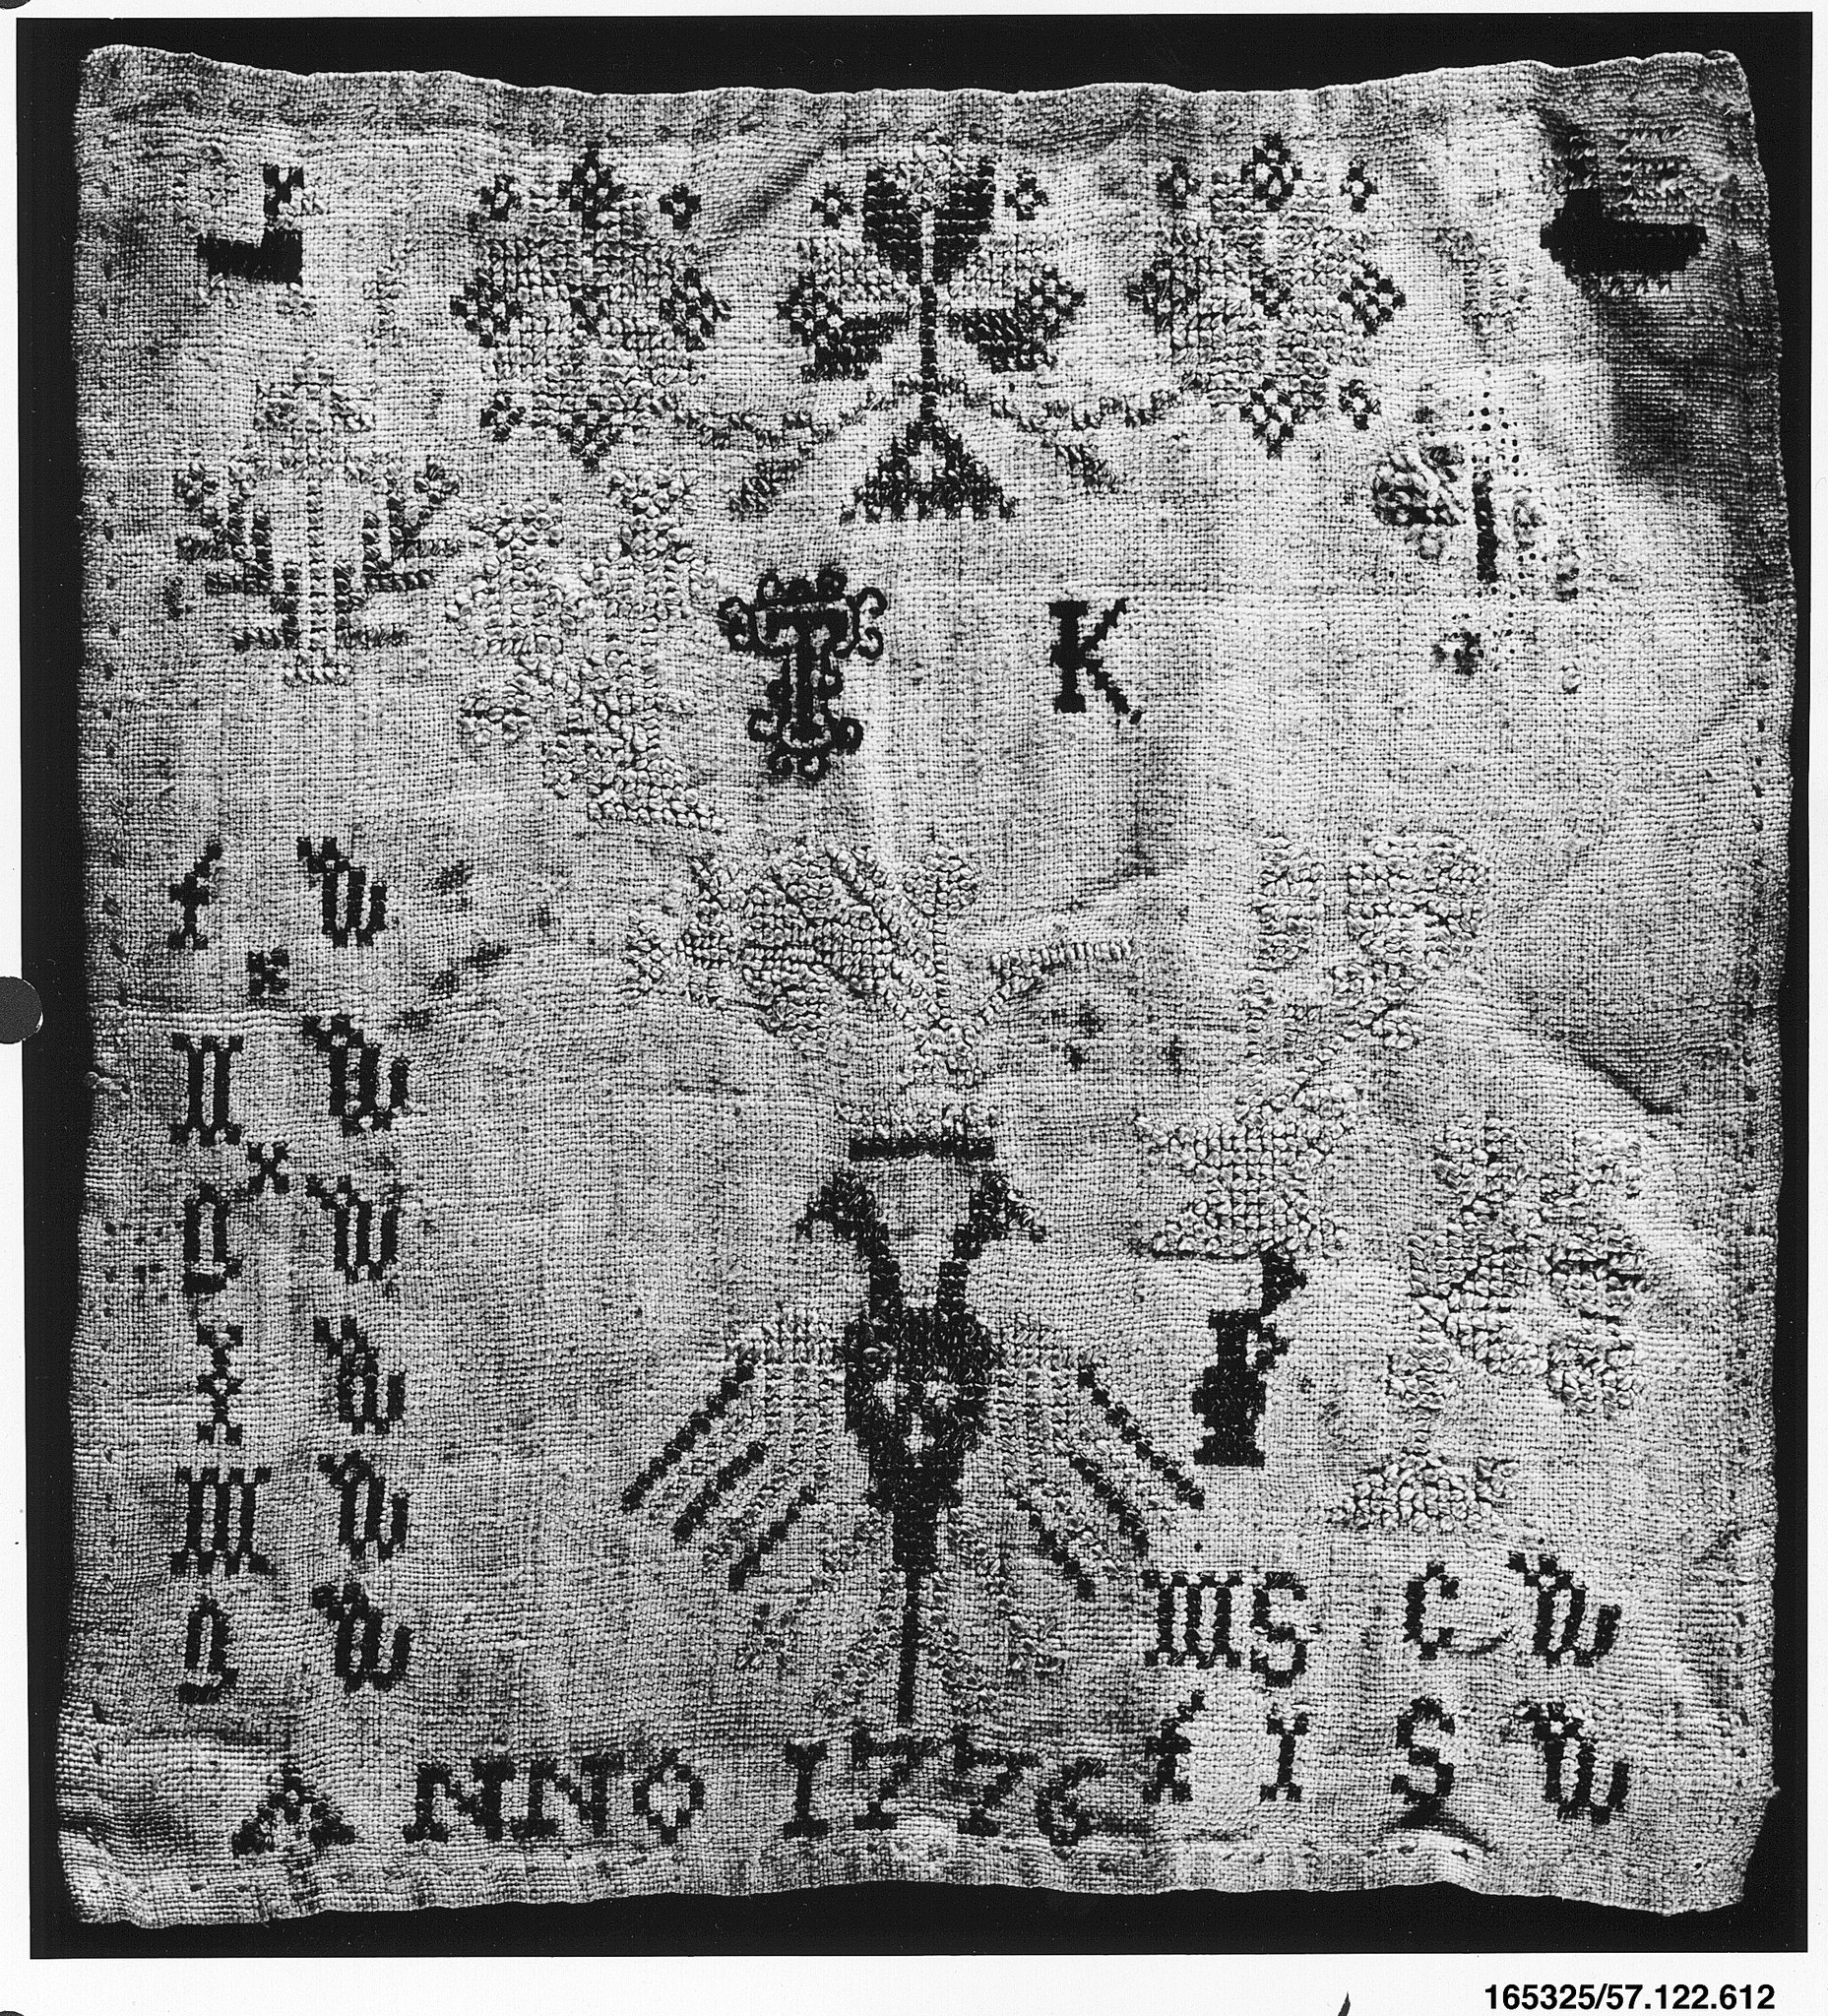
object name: sampler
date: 1776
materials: linen, silk